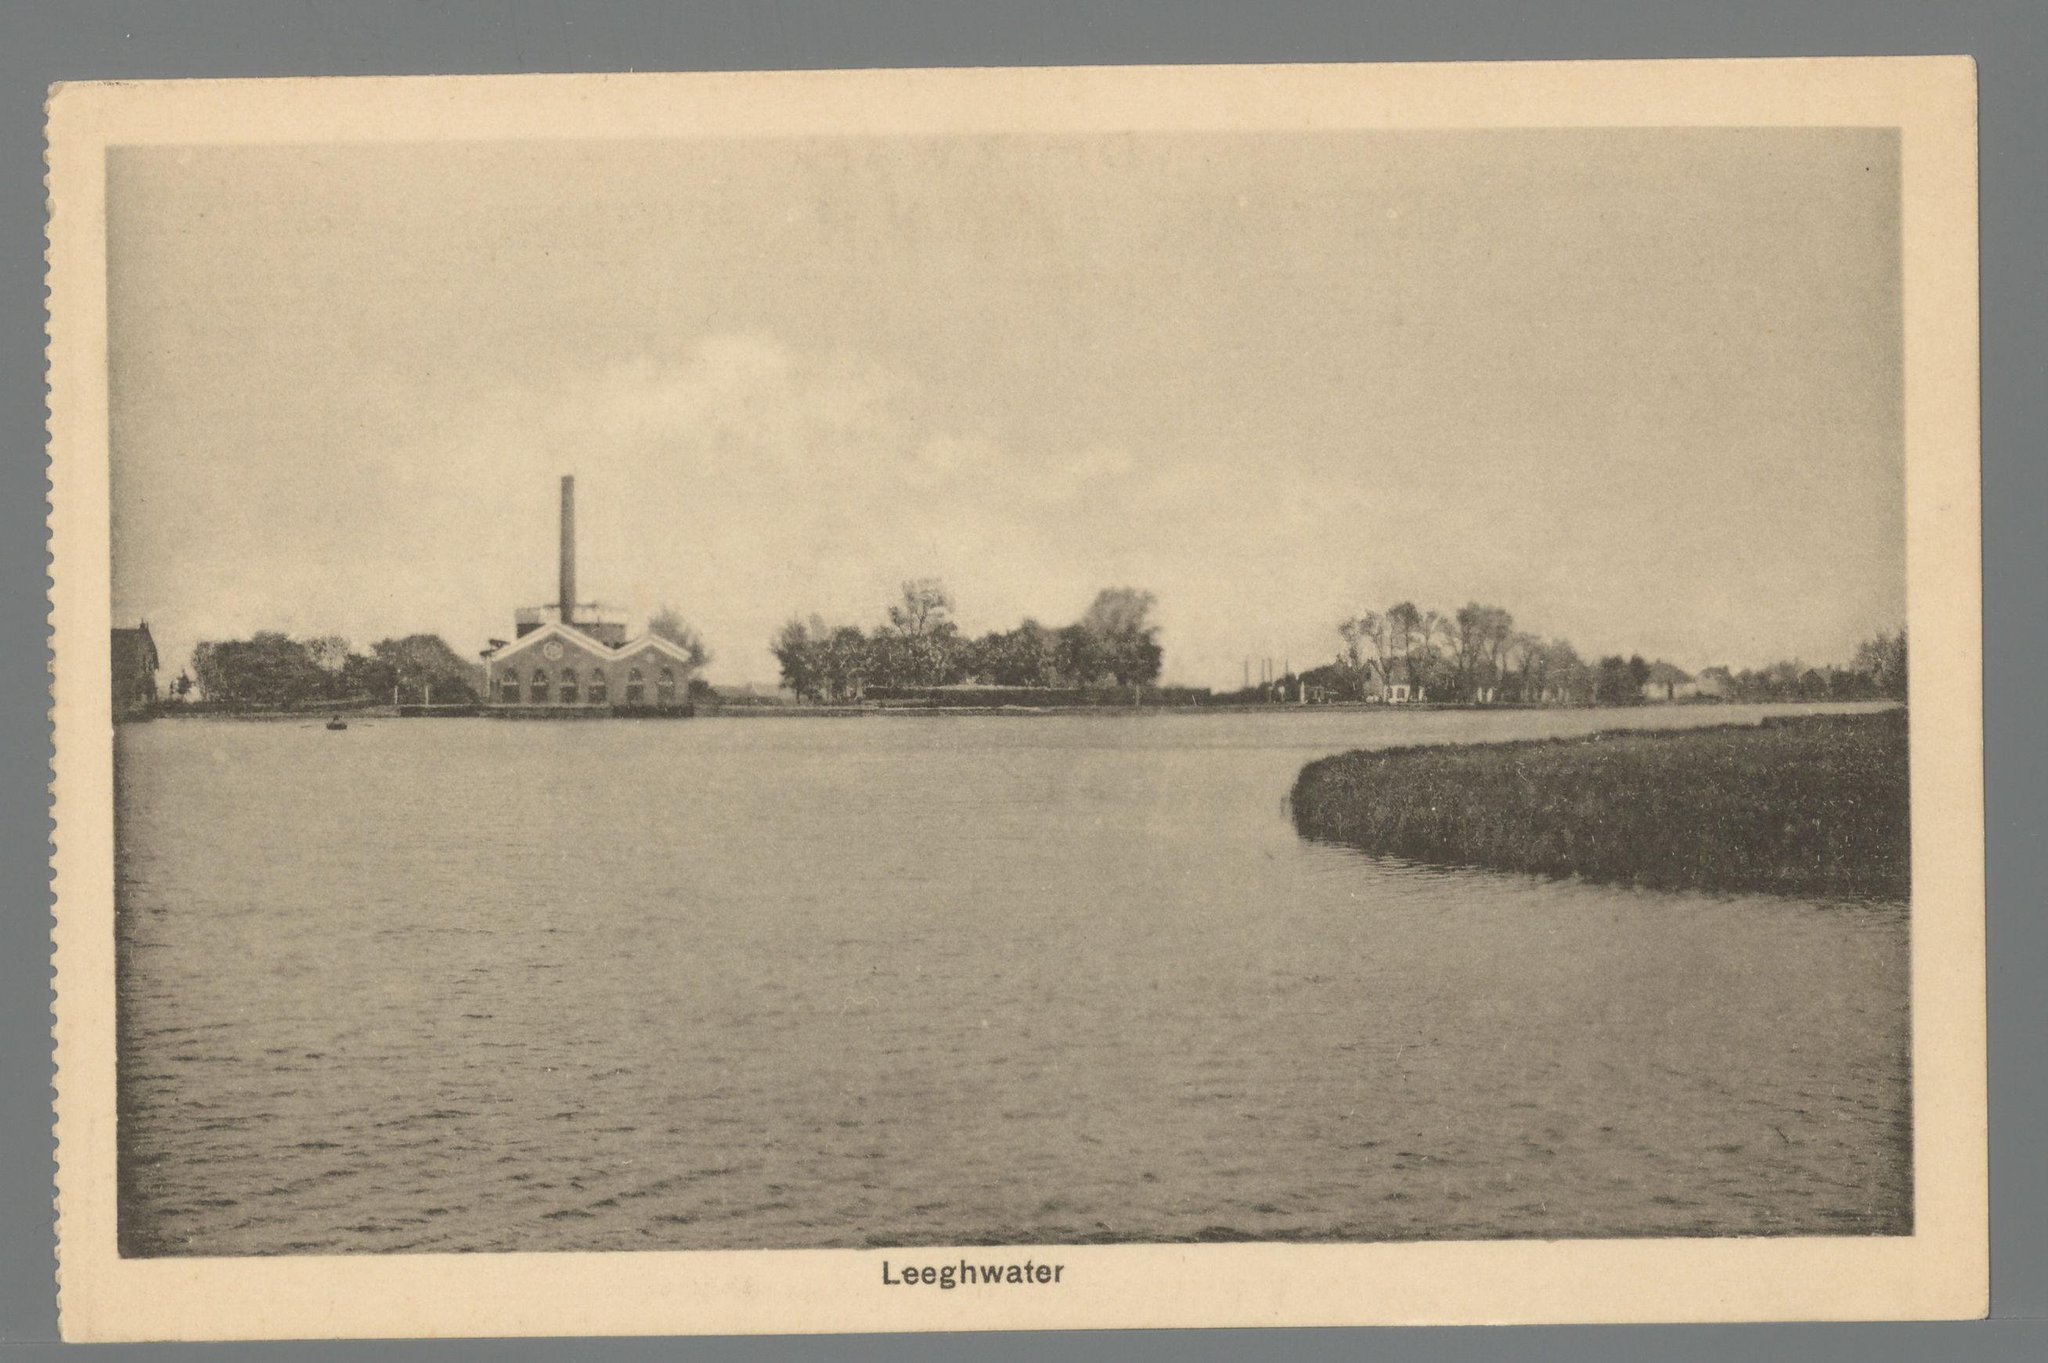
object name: photomechanical print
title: Leeghwater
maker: Anonymous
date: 1913-1930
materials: cardboard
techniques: photograph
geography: haarlem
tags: city-view, and landscape with man-made constructions, draining for land reclamation, lake